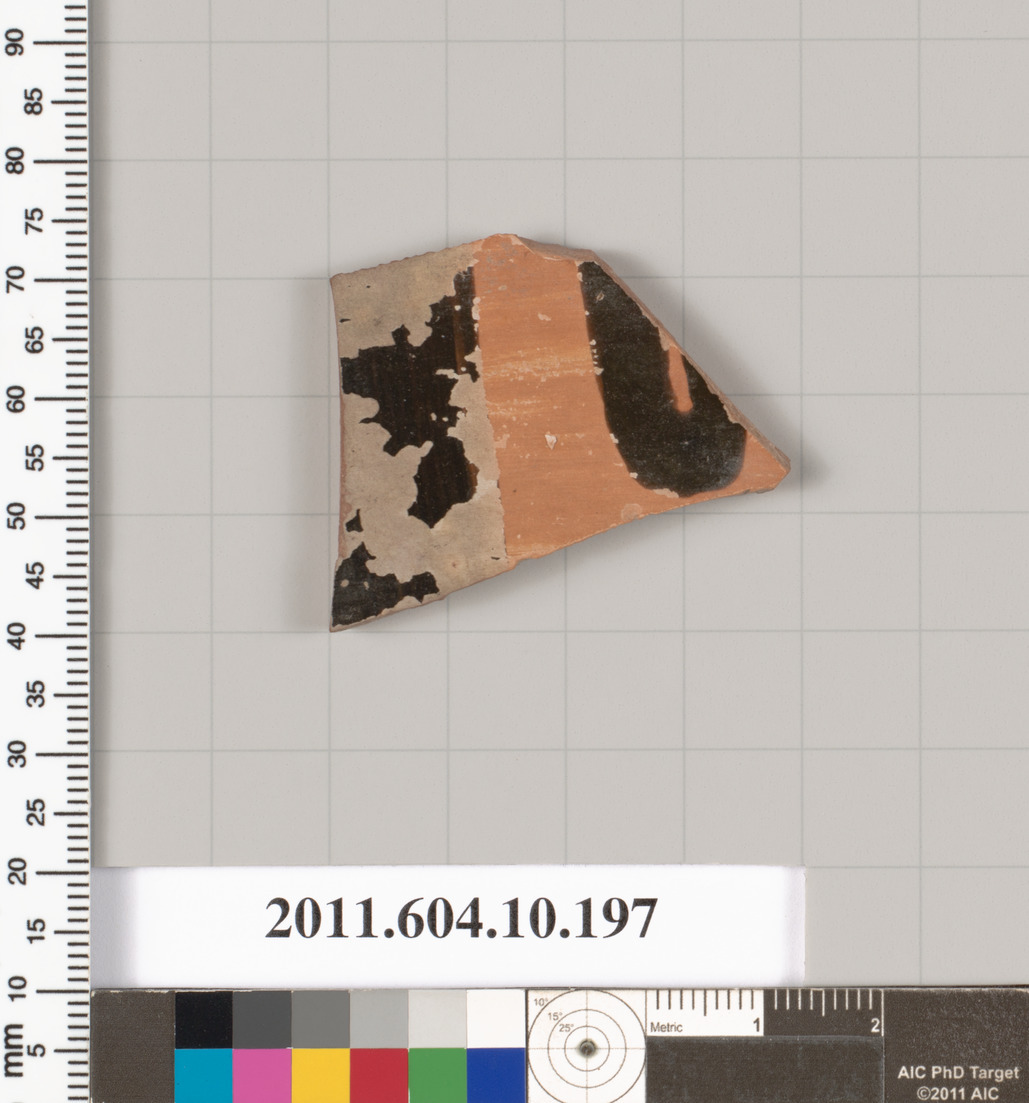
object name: undetermined closed shape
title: Terracotta fragment from a closed shape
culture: etruscan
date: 534-468 BCE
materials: terracotta